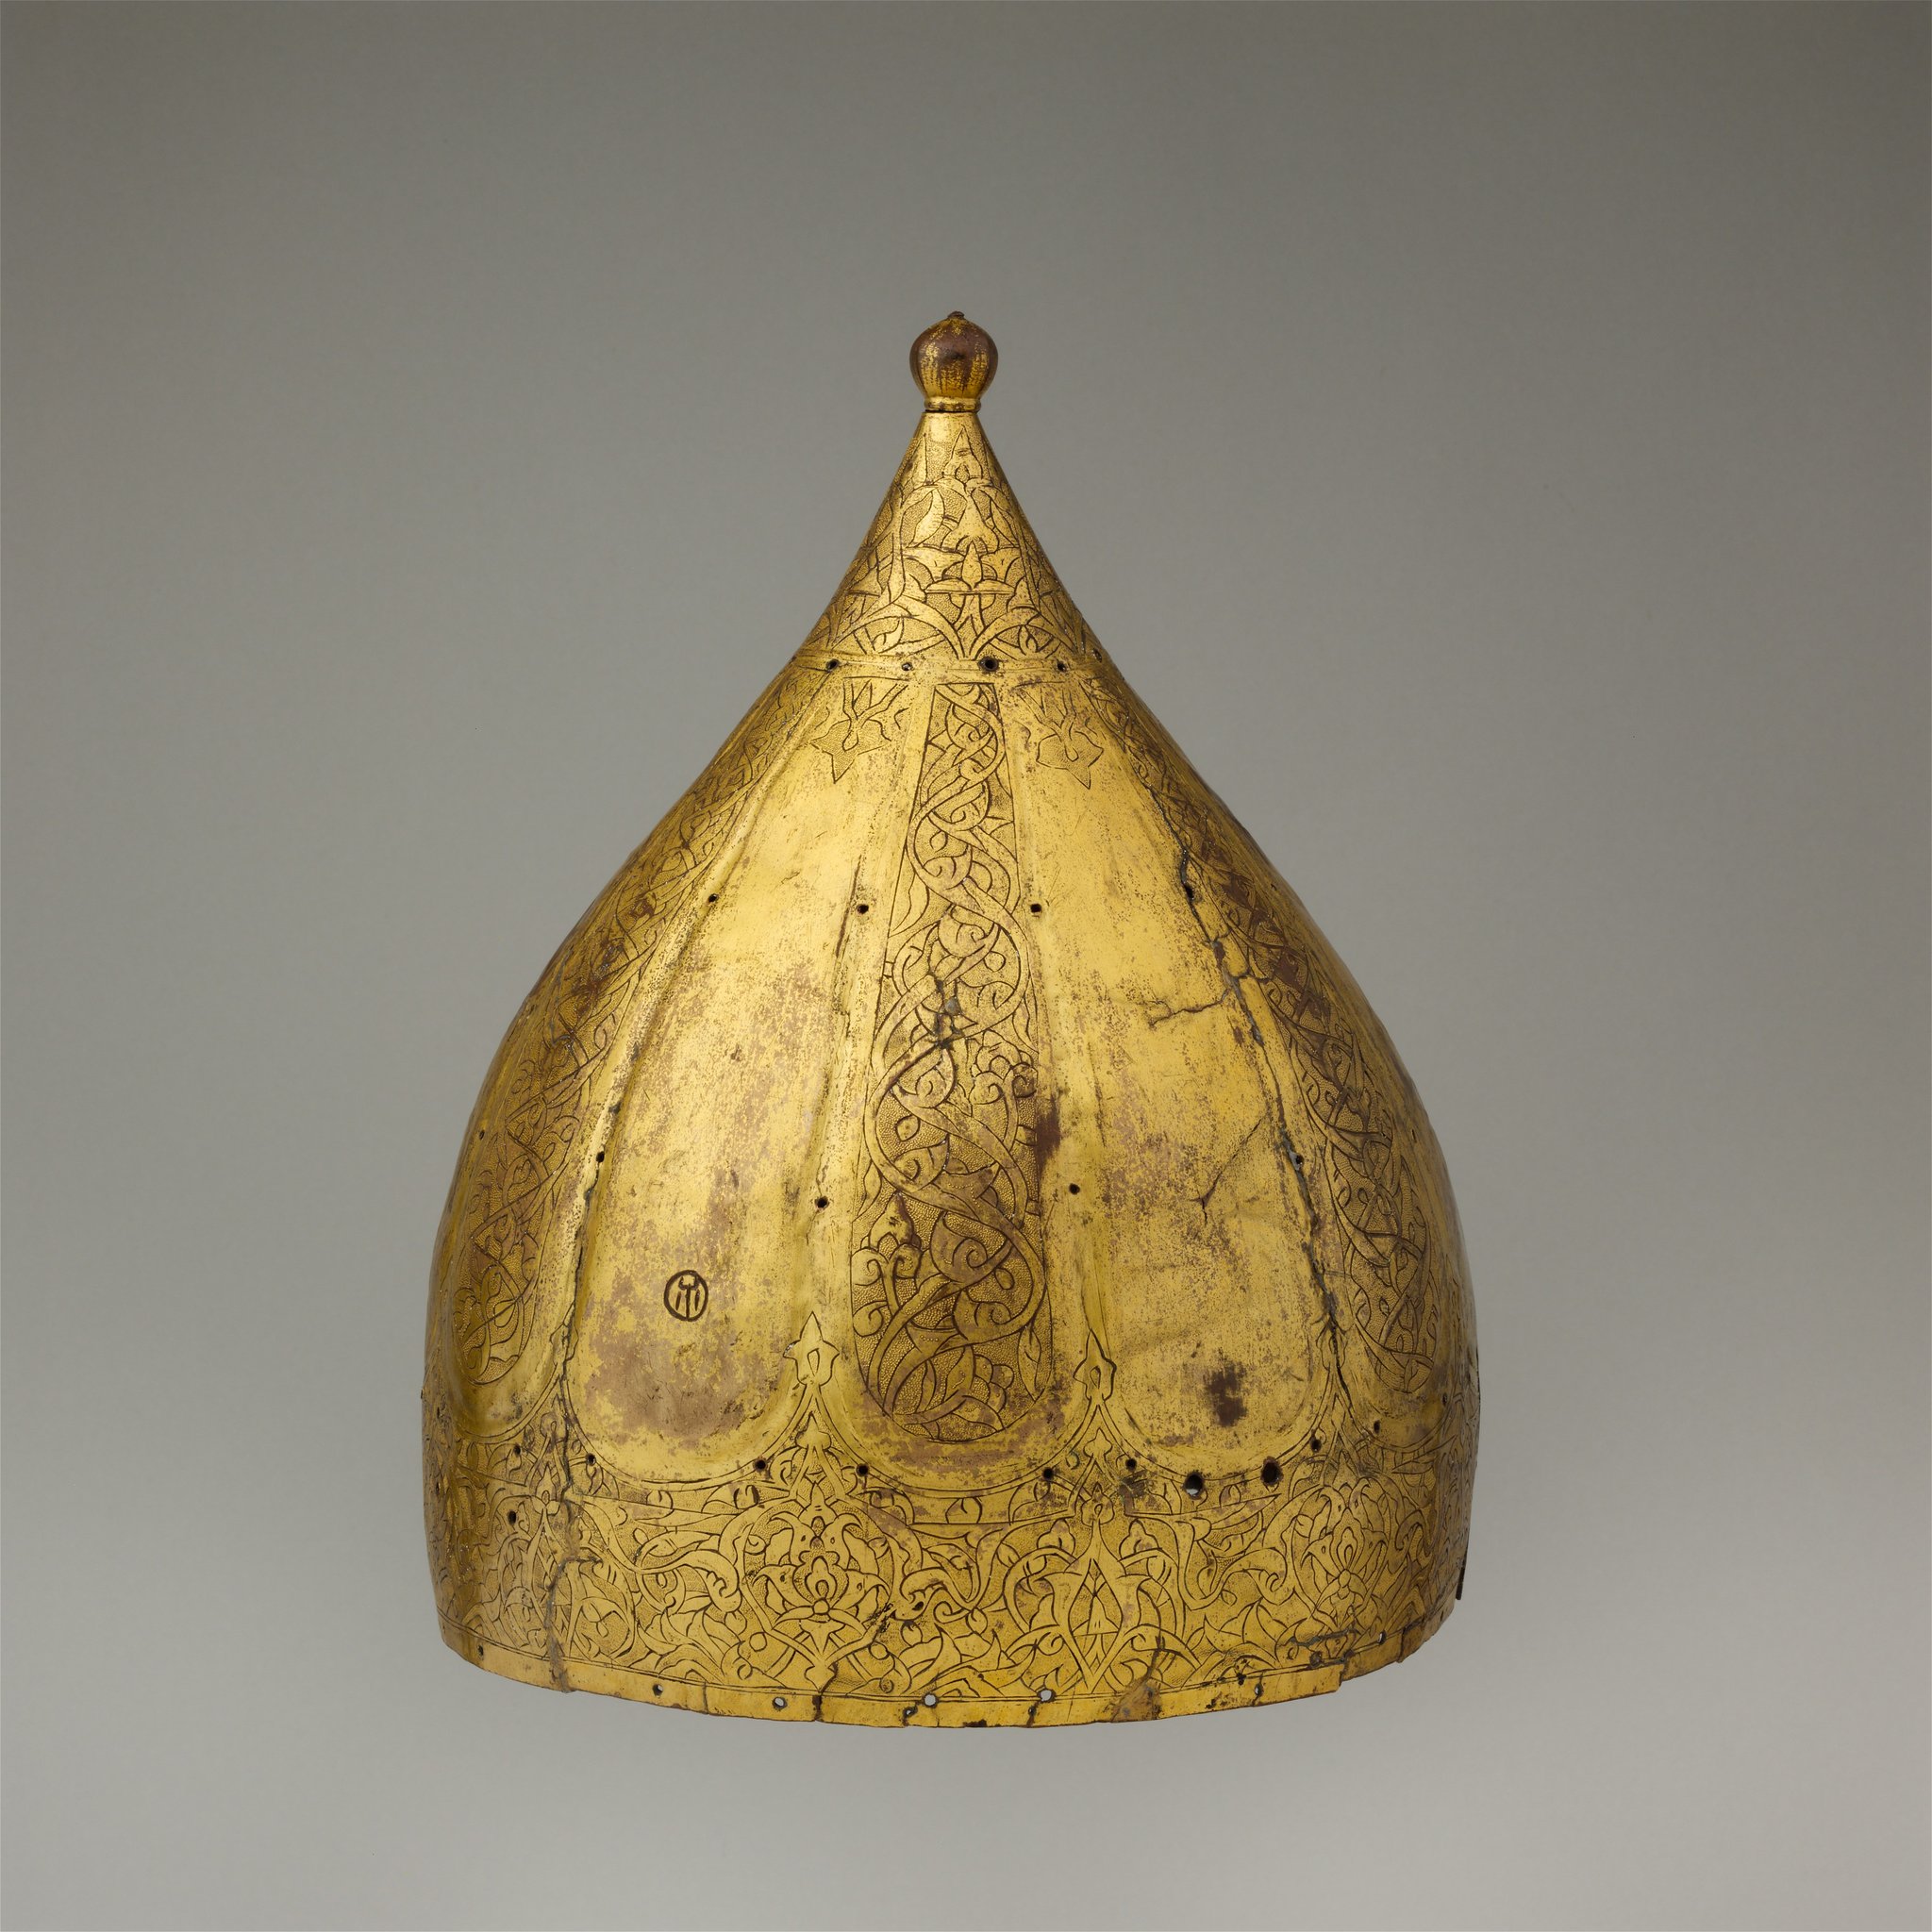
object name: helmet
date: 1601-1633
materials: copper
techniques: embossing, engraving, gilding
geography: turkey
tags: helmets